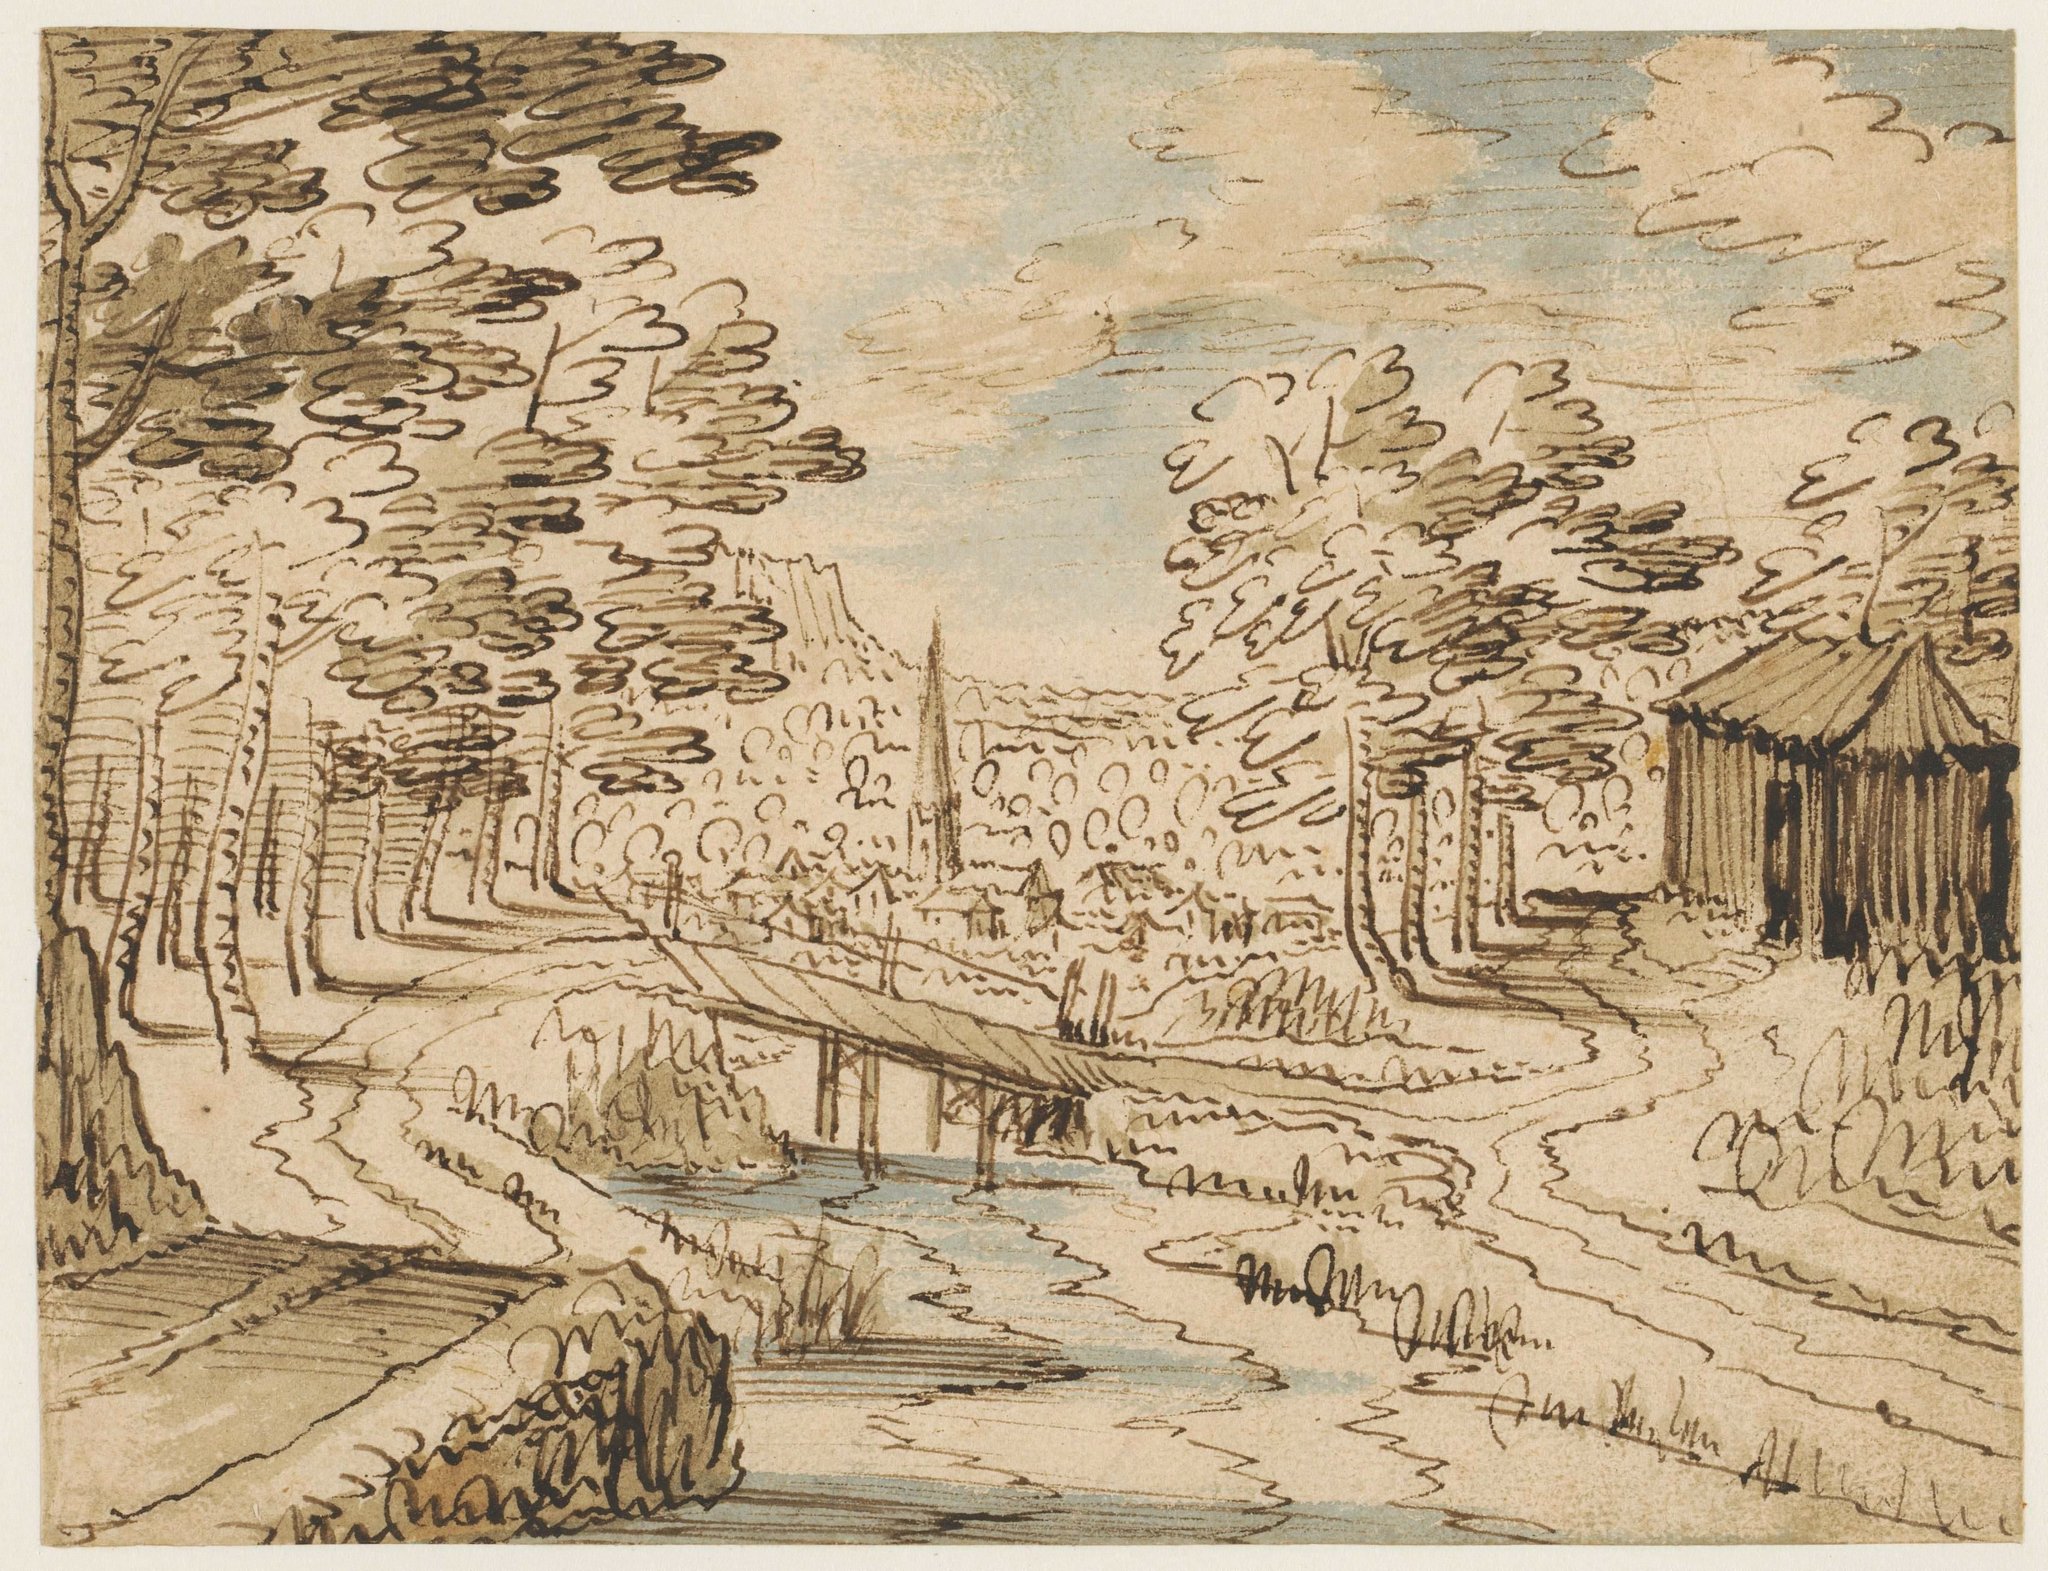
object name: drawing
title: Landschap met brug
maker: tobias verhaecht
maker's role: draughtsman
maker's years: 1561-1631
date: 1610-1650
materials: ink, paper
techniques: brush, pen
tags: public road in village, bridge in village across river, canal, etc.